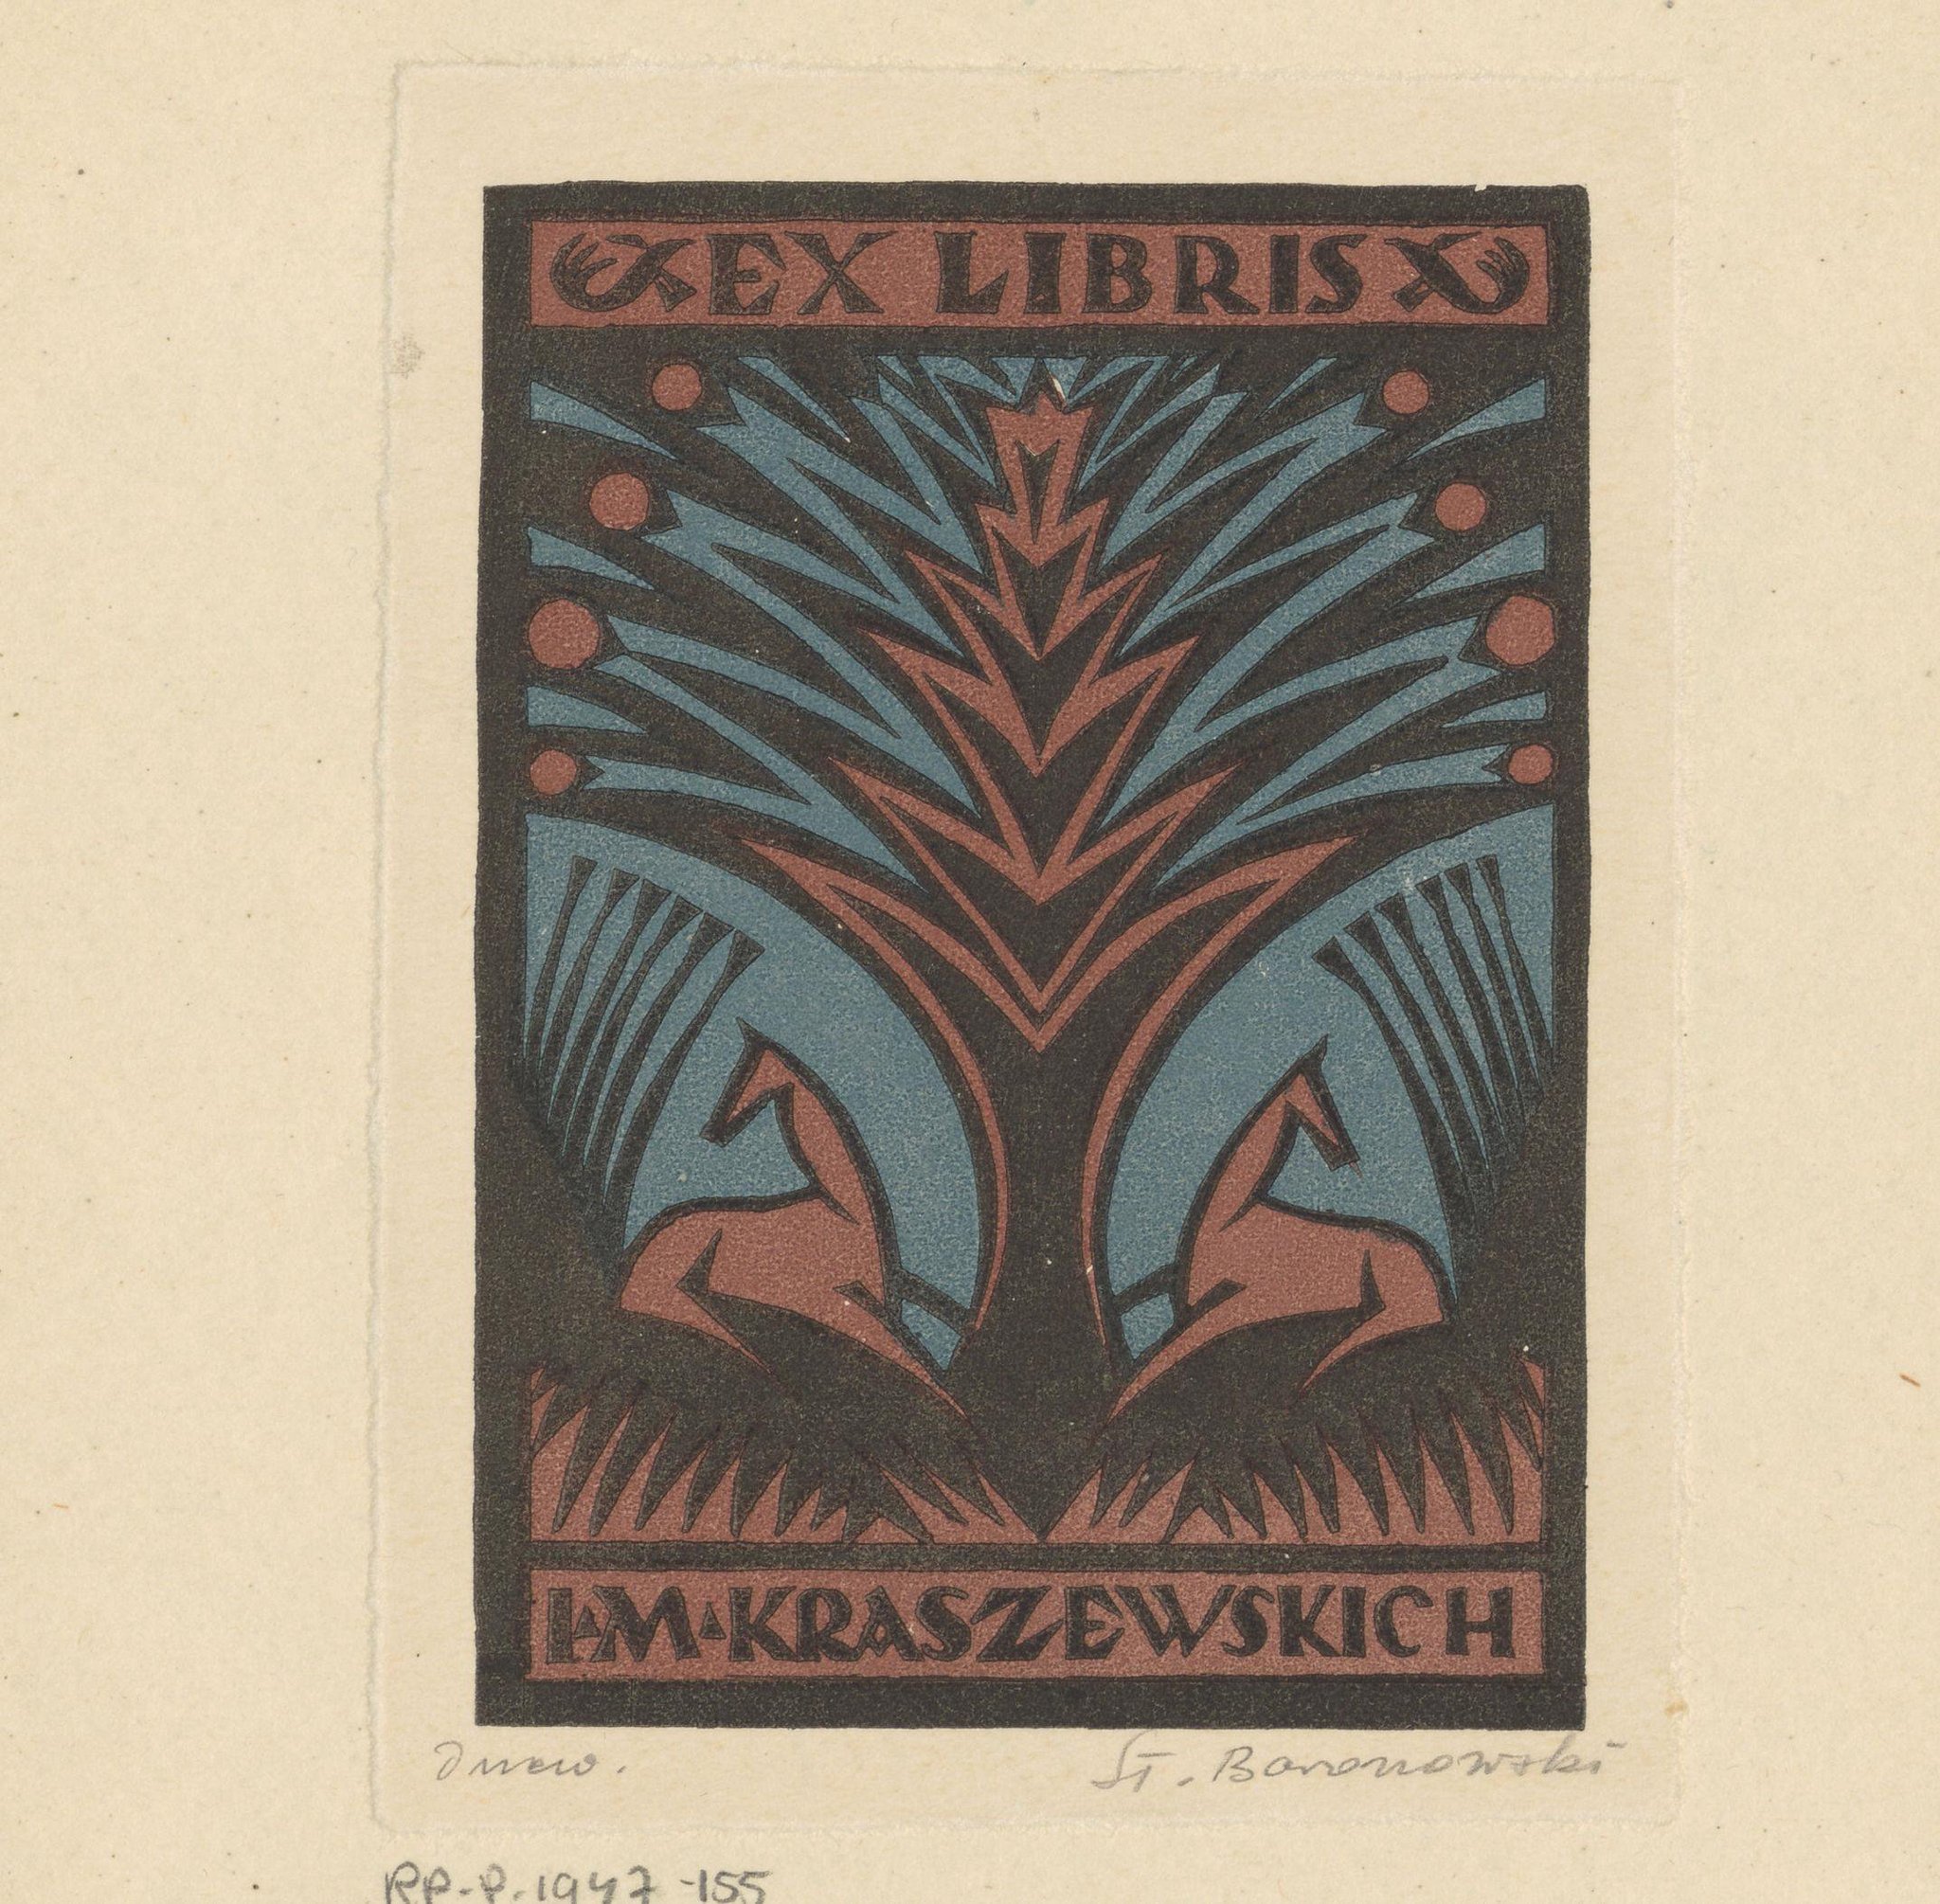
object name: bookplate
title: Ex libris I.M. Kraszewskich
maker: st. bonerowski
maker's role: print maker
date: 1900-1947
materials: paper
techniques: linocut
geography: poland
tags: mammals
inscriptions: collector's mark: Lugt 2228, signature: ‘[...] St. Bonerowski [?]’